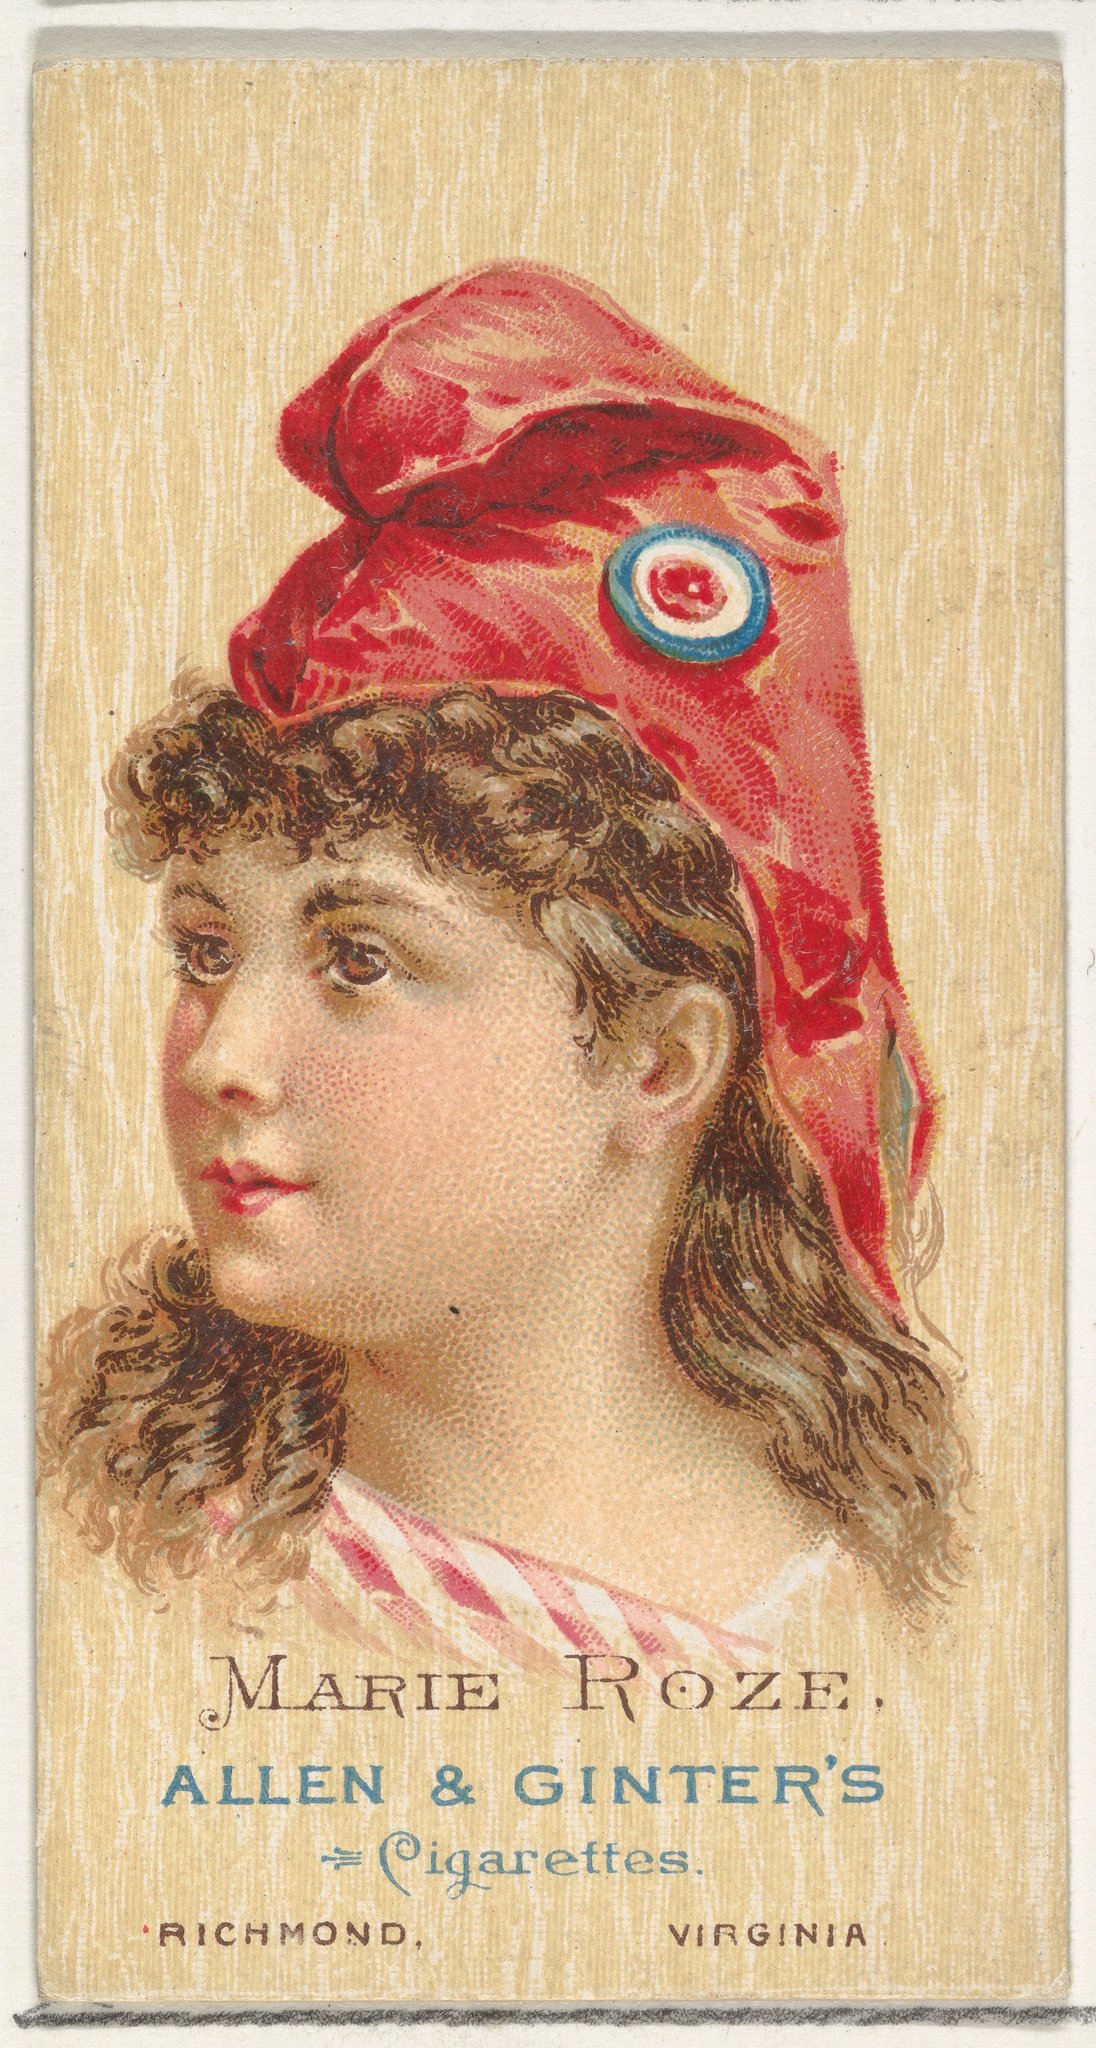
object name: print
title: Marie Roze, from World's Beauties, Series 2 (N27) for Allen & Ginter Cigarettes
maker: allen & ginter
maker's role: publisher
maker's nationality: american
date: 1888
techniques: color lithograph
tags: women